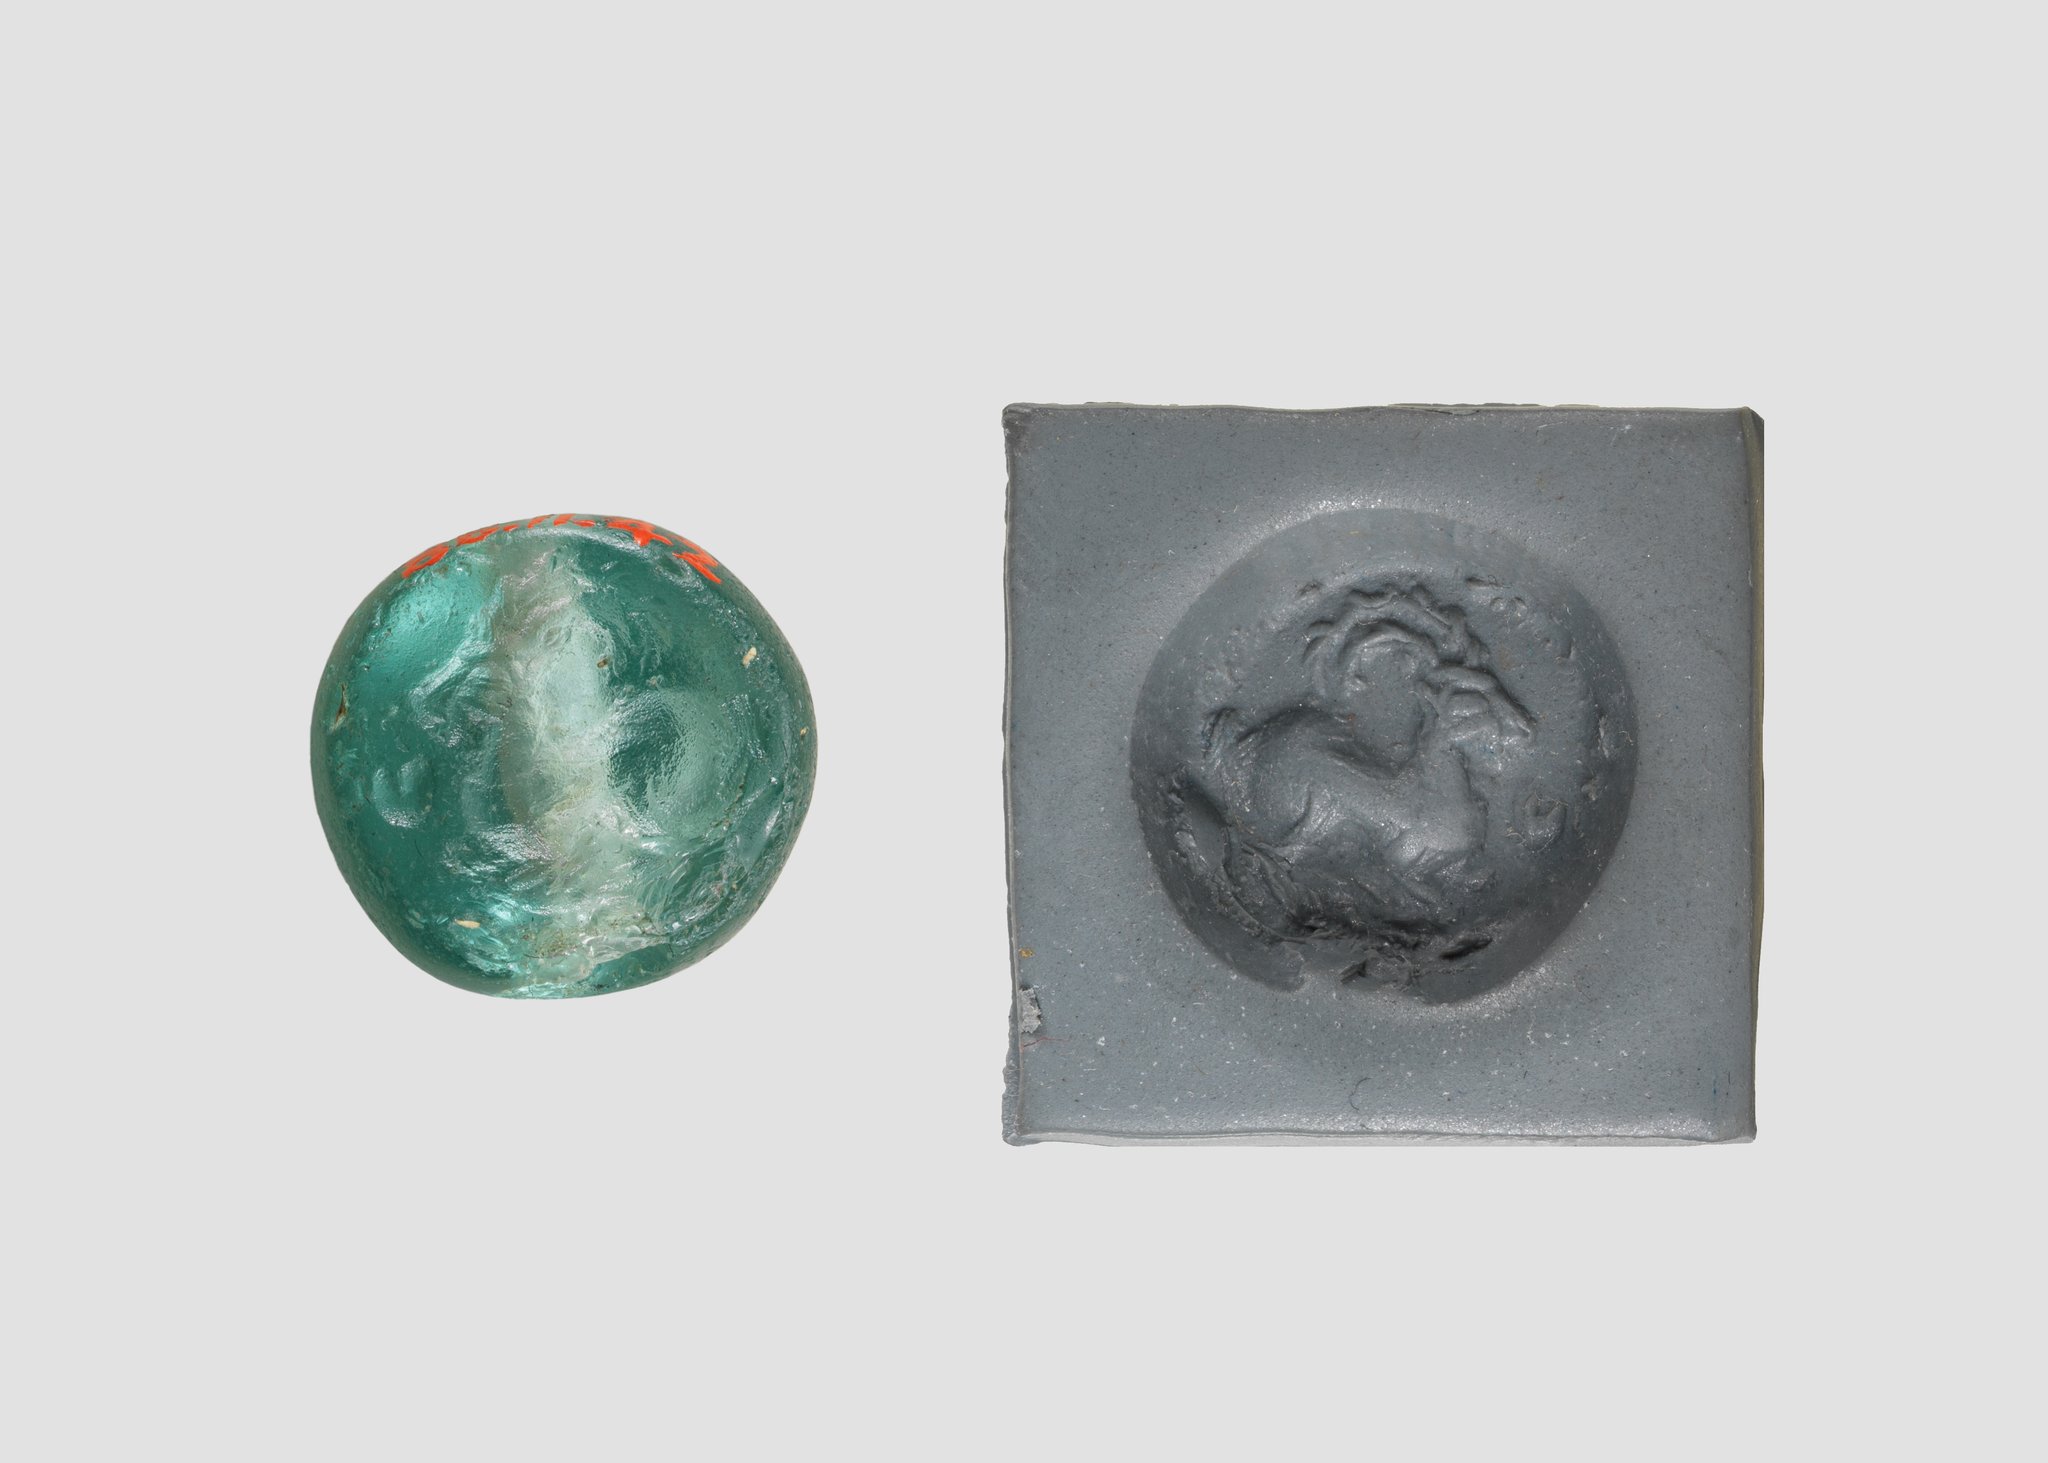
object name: stamp seal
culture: sasanian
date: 201-700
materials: glass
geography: iran or mesopotamia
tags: animals